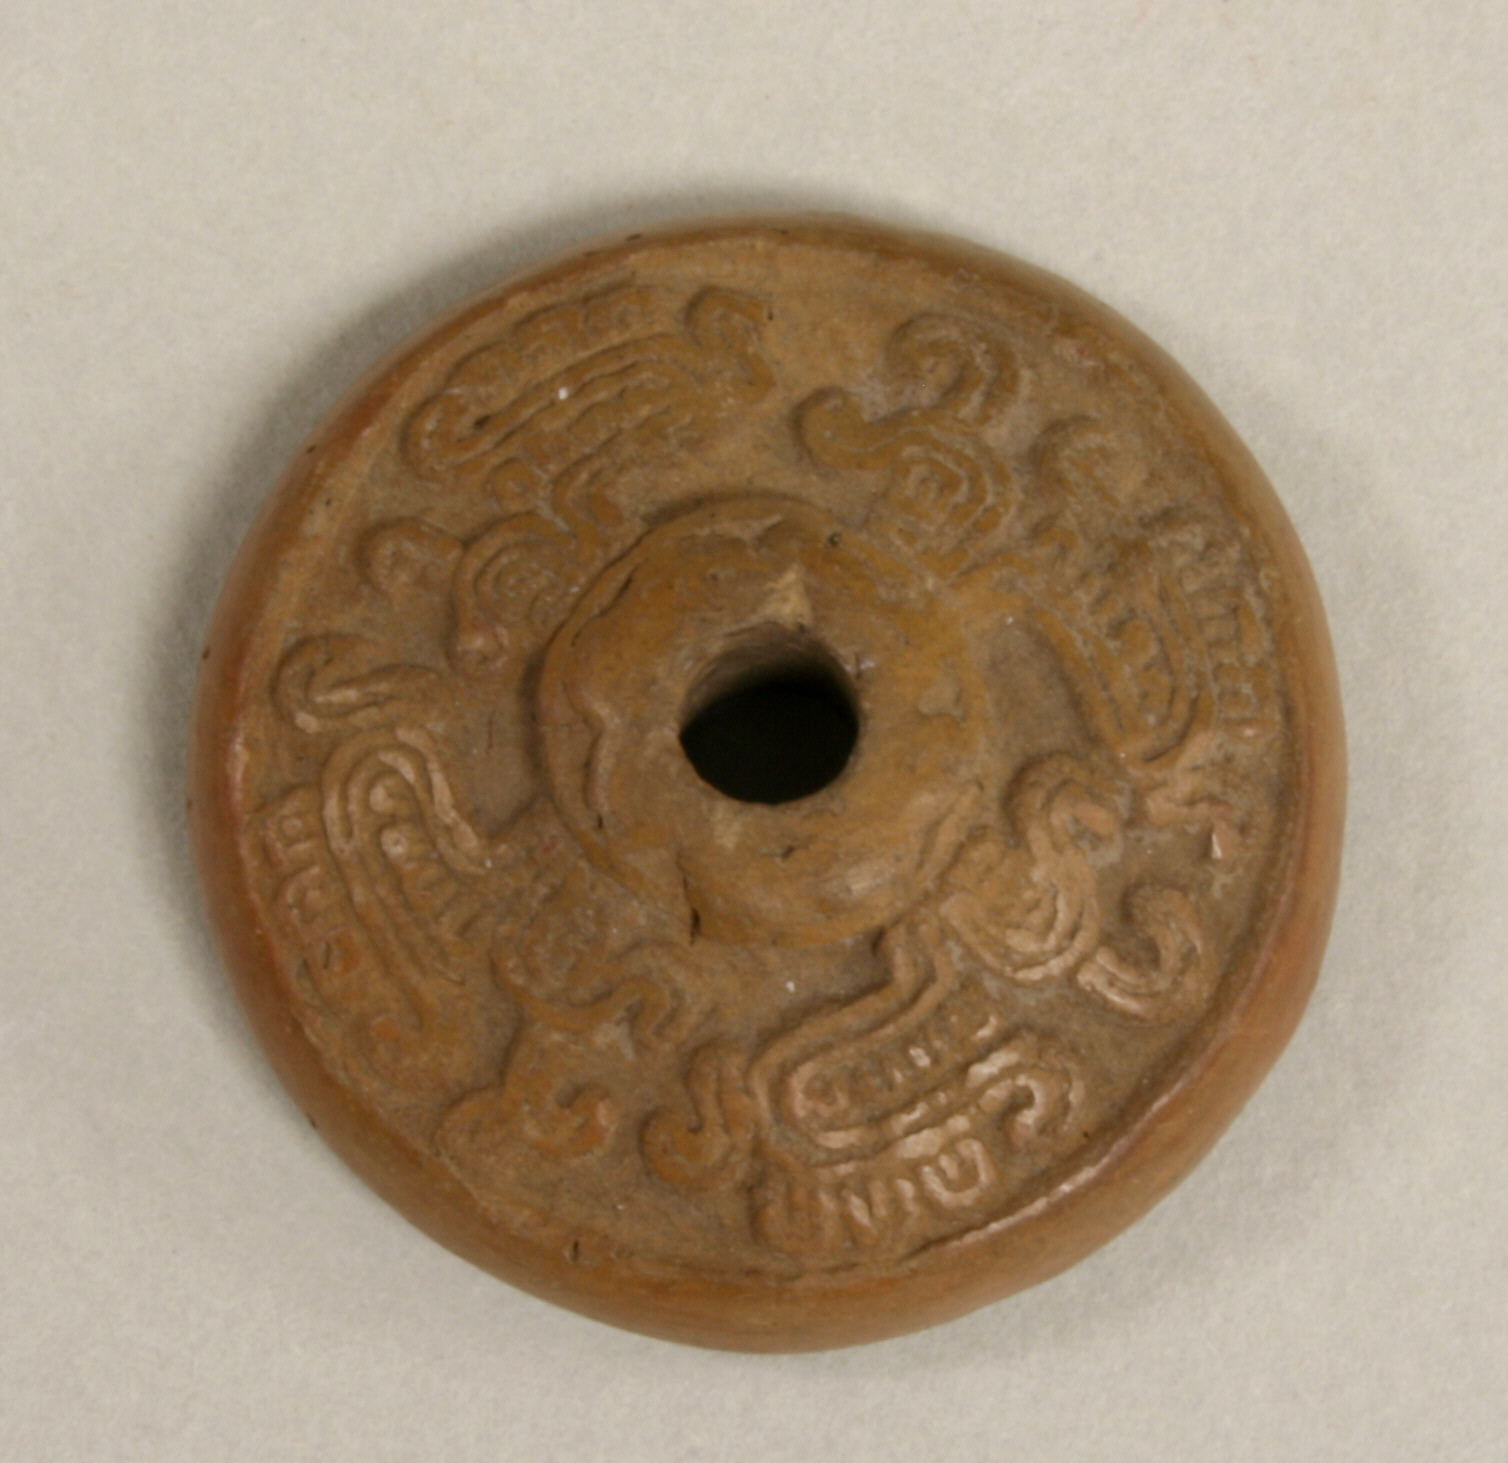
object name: spindle whorl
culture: mexican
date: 801-1500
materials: ceramic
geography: mexico